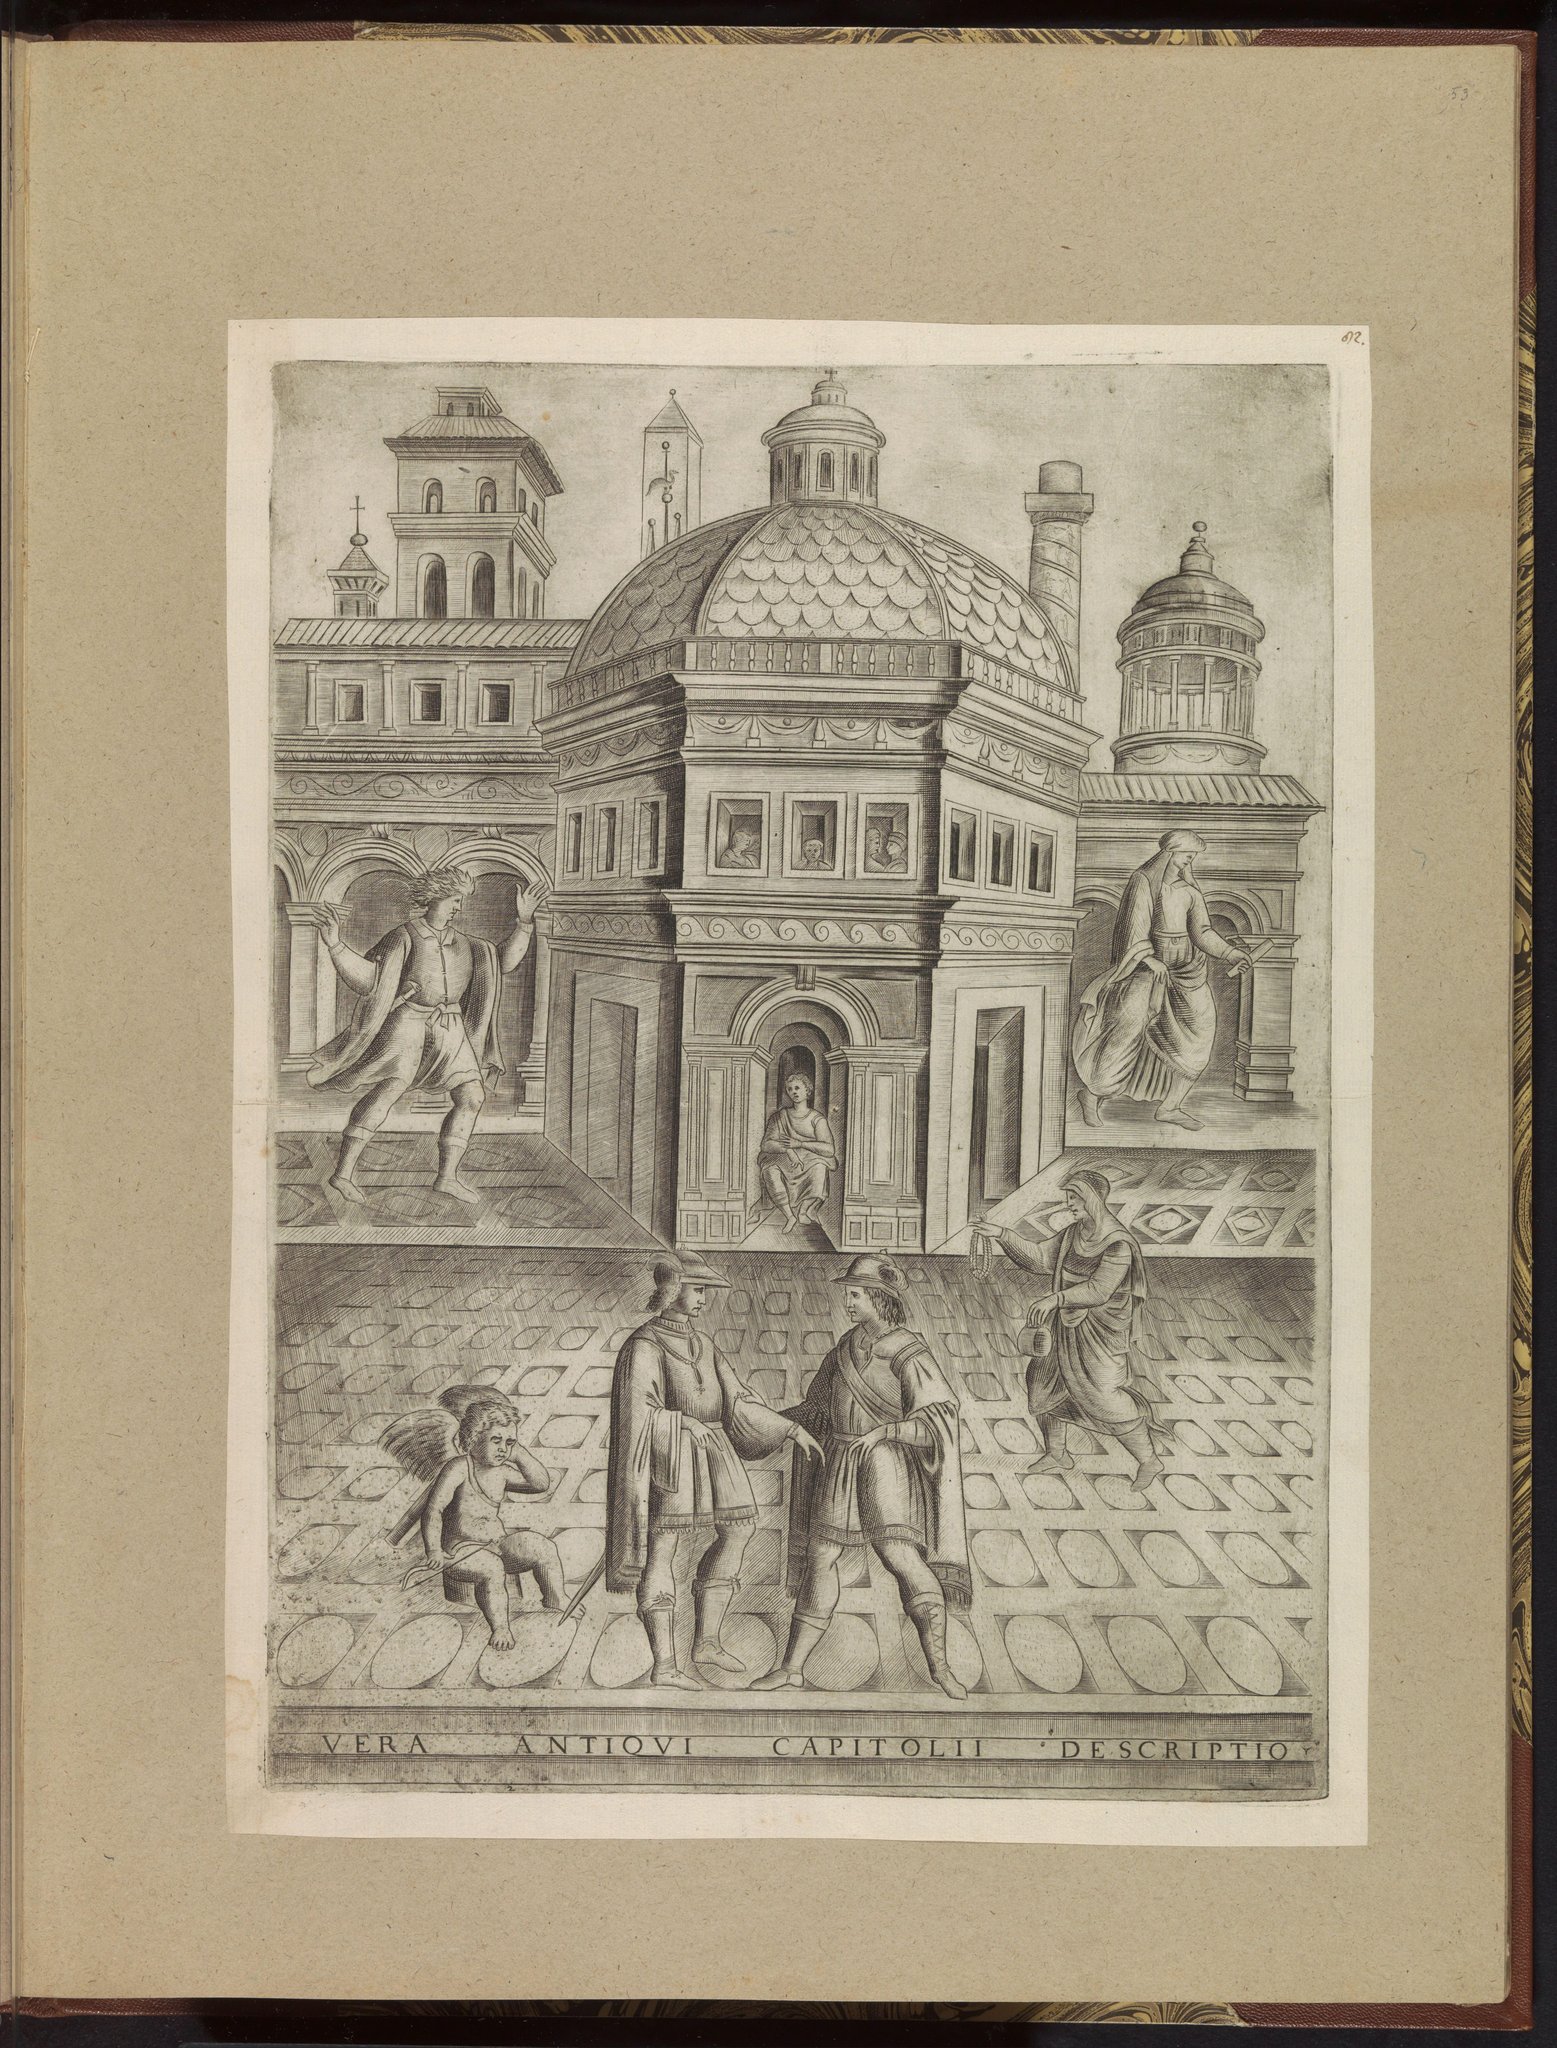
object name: album leaf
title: Vera Antiqui Capitolii Descriptio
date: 1595-1622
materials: paper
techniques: engraving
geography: italy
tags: city-view, and landscape with man-made constructions, sleeping cupid; possibly signifying a slackening of love's influence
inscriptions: number: ‘82’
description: Deze prent kan samen met twee andere prenten in het album tot een drieluik worden samengeplakt. Deze prent behoort tot het prentcorpus dat bekend staat als de ‘Speculum Romanae Magnificentiae’ (‘Spiegel van Romeinse pracht’). Dit corpus, bestaande uit prenten met voorstellingen van kunstwerken en gebouwen uit het antieke en het moderne Rome, vond zijn oorsprong bij uitgevers Antonio Salamanca en Antonio Lafreri. Deze twee buitenlandse uitgevers bundelden hun krachten te Rome in de periode 1553-1563. Hun prenten werden al snel razend populair bij toeristen en verzamelaars, die de prenten individueel of in grote groepen aanschaften. Grote groepen Speculum-prenten werden vaak op aanvraag samengebonden in albums. Er zijn verschillende Speculum-albums overgeleverd die allemaal verschillen van inhoud. Tussen 1573 en 1577 gaf Antonio Lafreri een speciale titelpagina uit (met de titel ‘Speculum Romanae Magnificentiae’) die mensen voor hun verzamelingen konden voegen. Het overlijden van Lafreri in 1577 betekende niet het einde van het corpus. Een groot deel van de koperplaten ging over op Claudio en Stefano Duchetti. De rest raakte verspreid over verschillende andere uitgevers. De populariteit van de Speculum-prenten wist nog geruime periode uitgevers te inspireren tot het laten maken van kopieën en het toevoegen van nieuwe prenten aan het corpus.